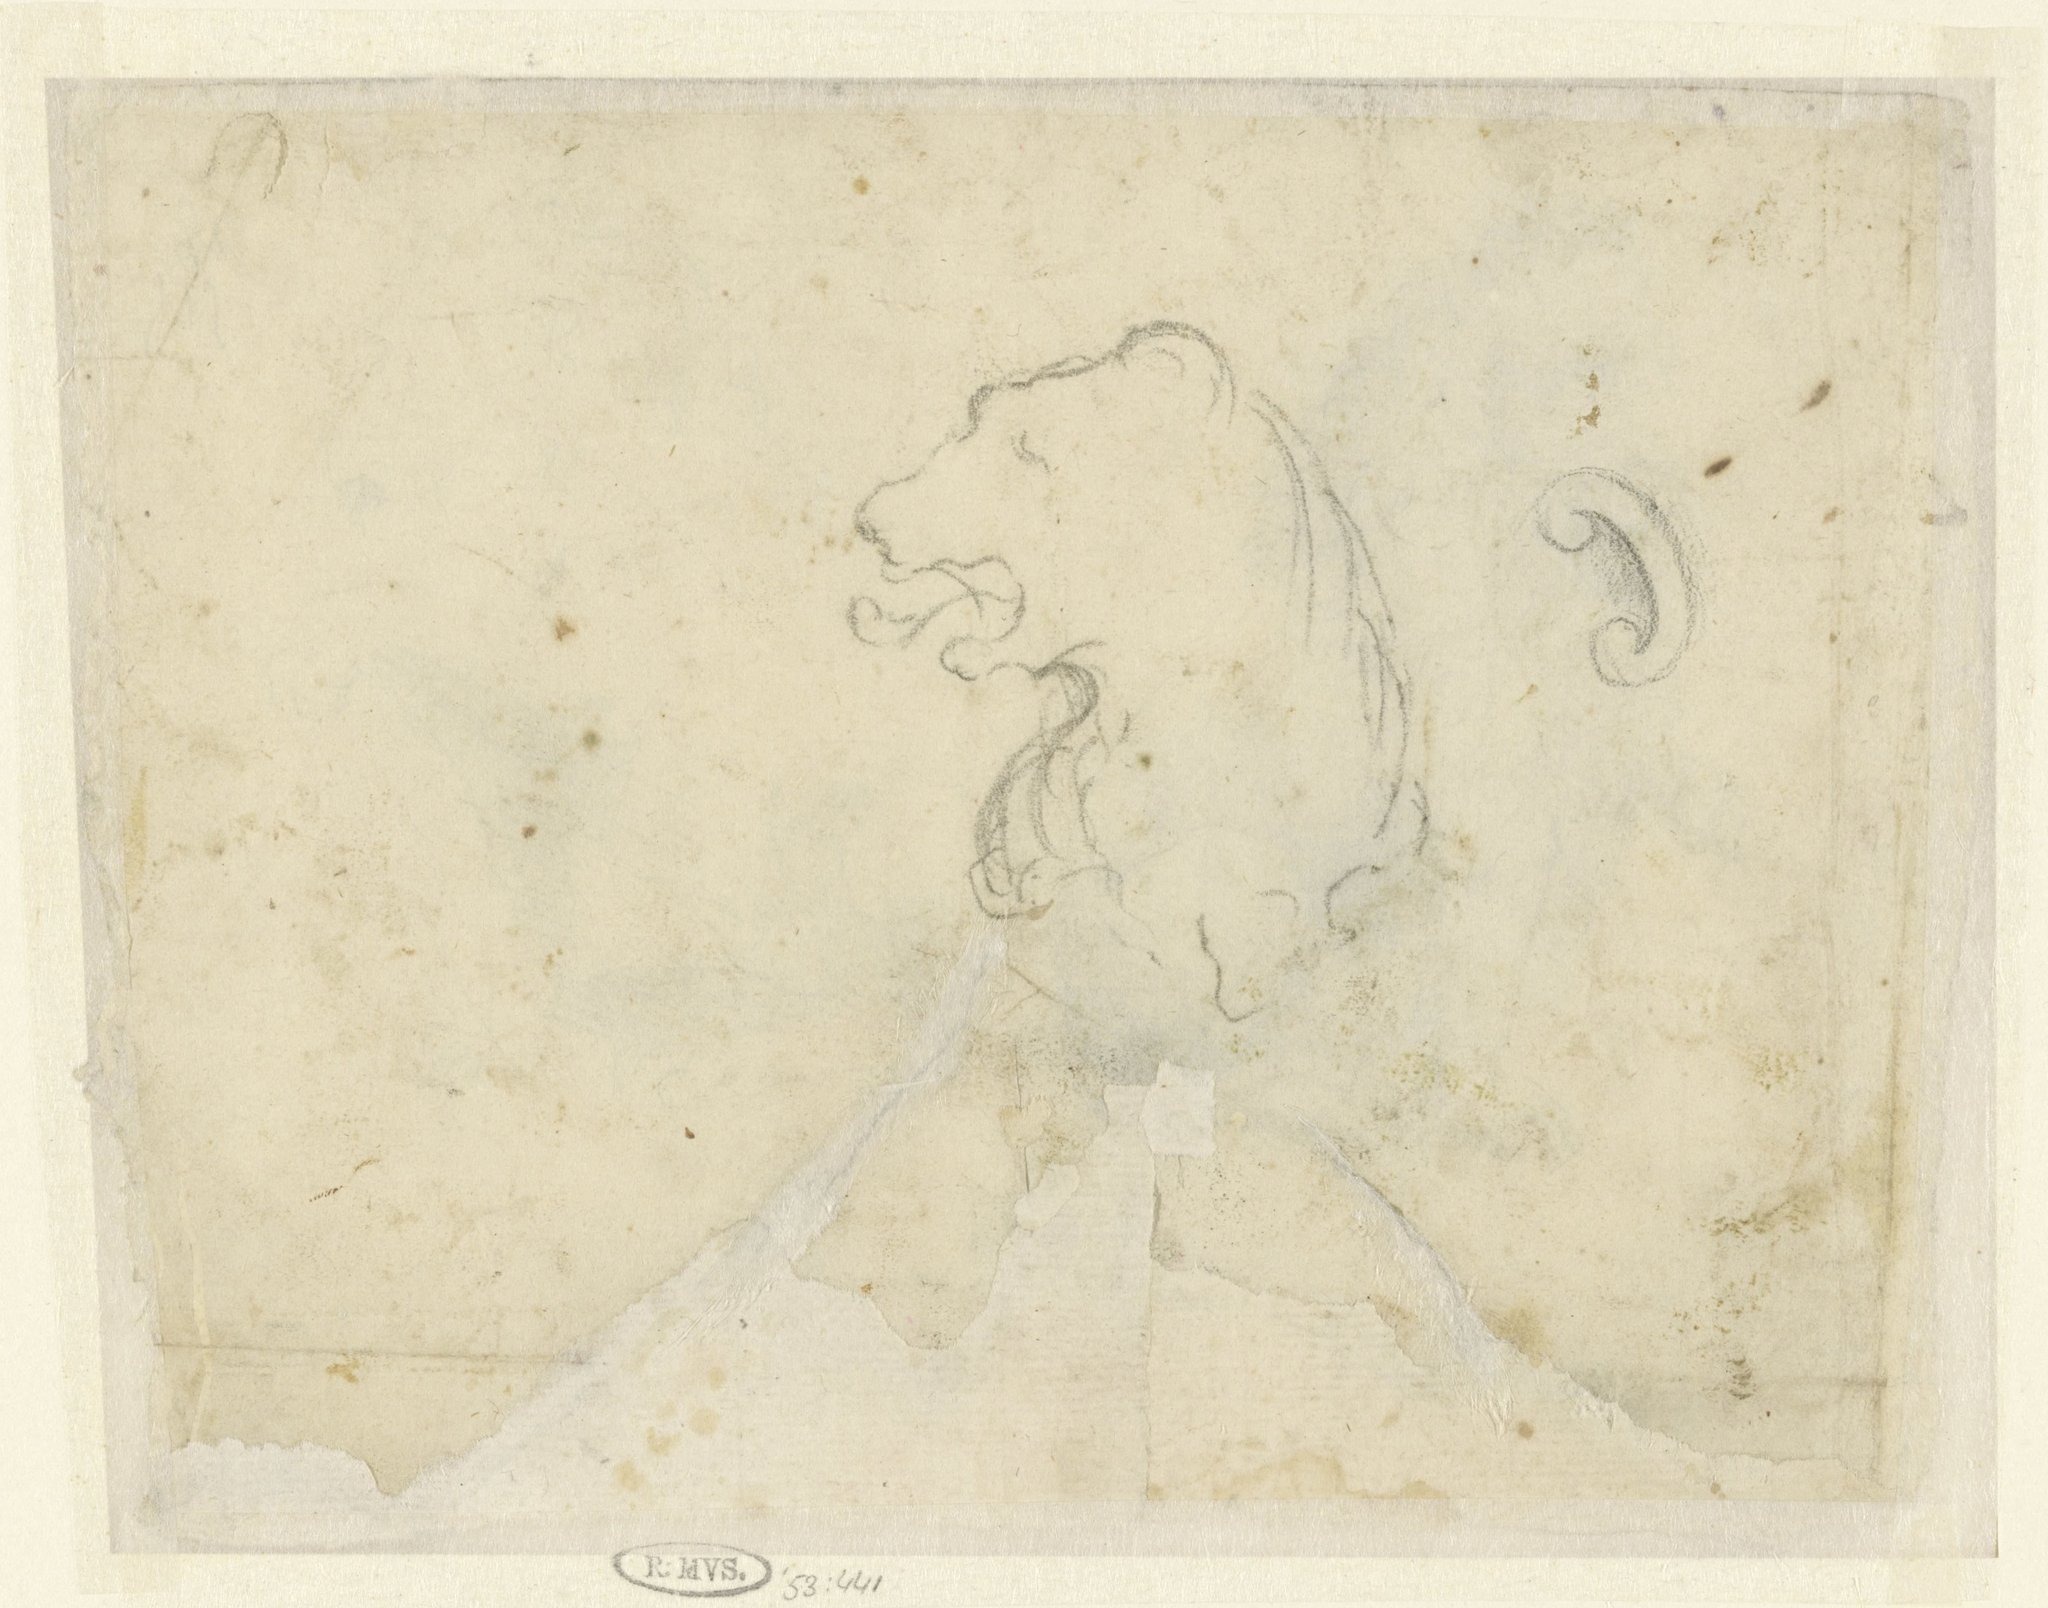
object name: drawing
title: Studie naar een beeld van een leeuw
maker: Anonymous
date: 1480-1520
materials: chalk, paper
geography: florence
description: Een studie naar een beeld van een leeuw (Donatello's Marzocco?).